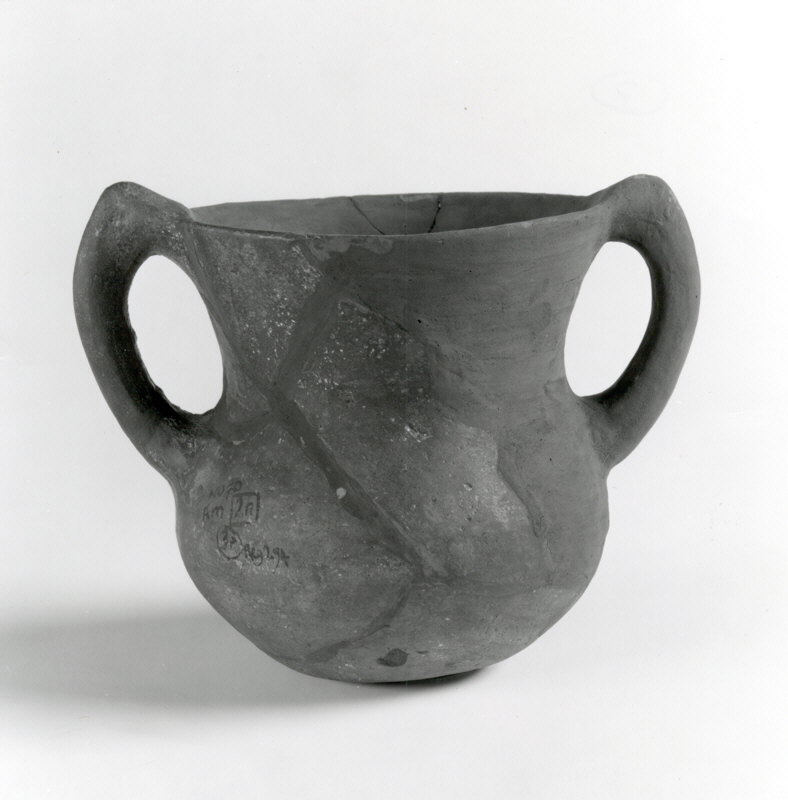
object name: jar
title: Two-handled jar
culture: iranian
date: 700-601 BCE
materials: ceramic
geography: iran